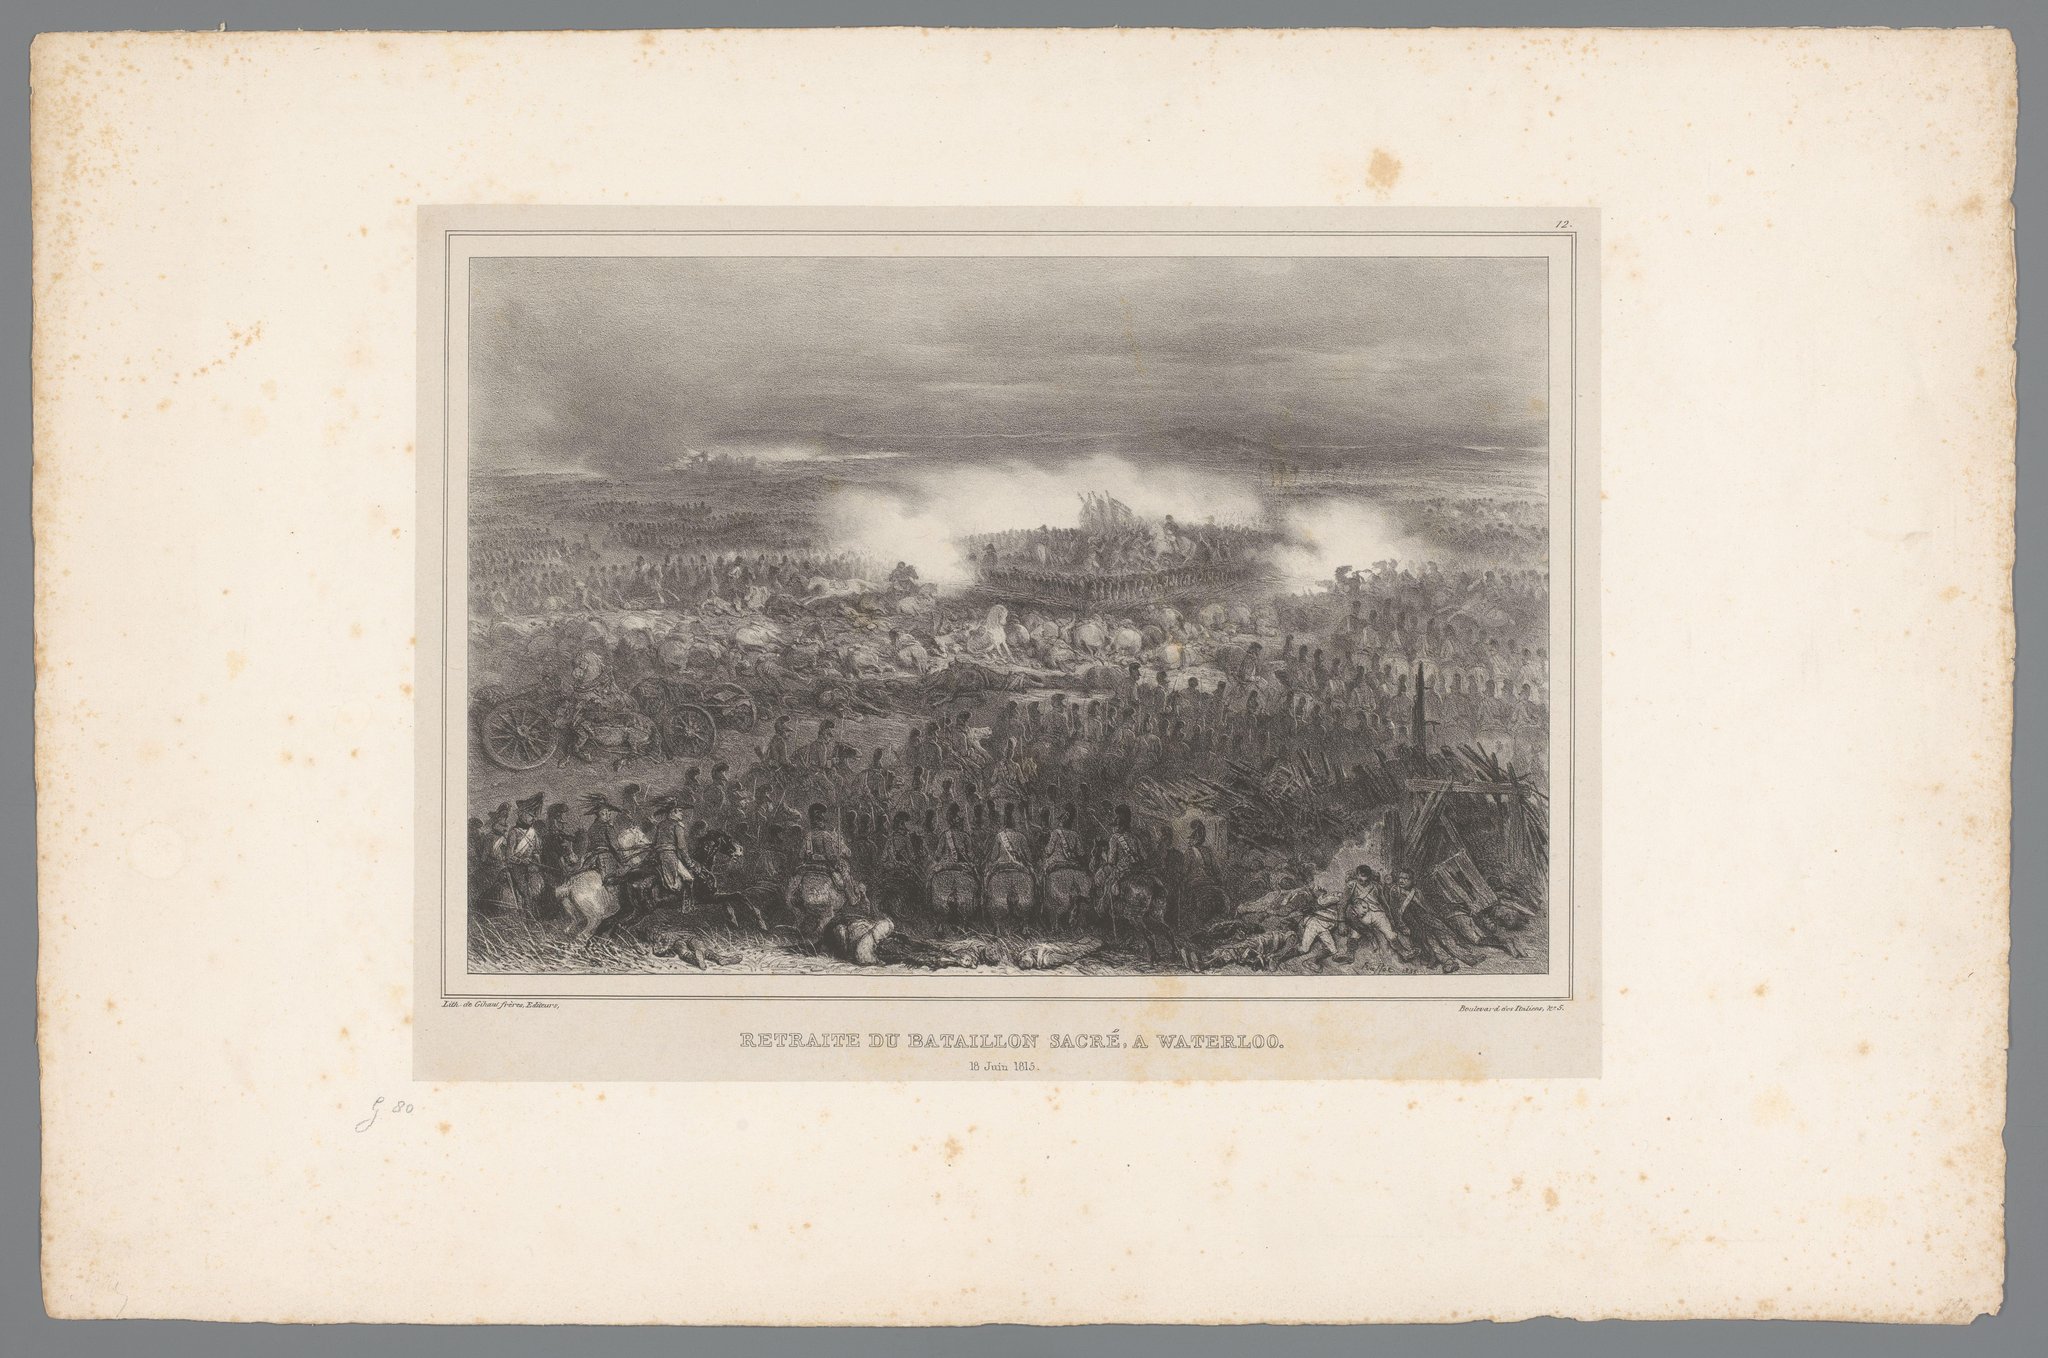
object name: print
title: Terugtocht van een bataljon bij Waterloo, 18 juni 1815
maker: denis auguste marie raffet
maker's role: draughtsman, print maker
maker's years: 1804-1860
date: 1835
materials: paper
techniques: lithograph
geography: paris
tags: after the battle, retreat of the defeated, division of armed forces, waterloo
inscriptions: collector's mark: Lugt 964